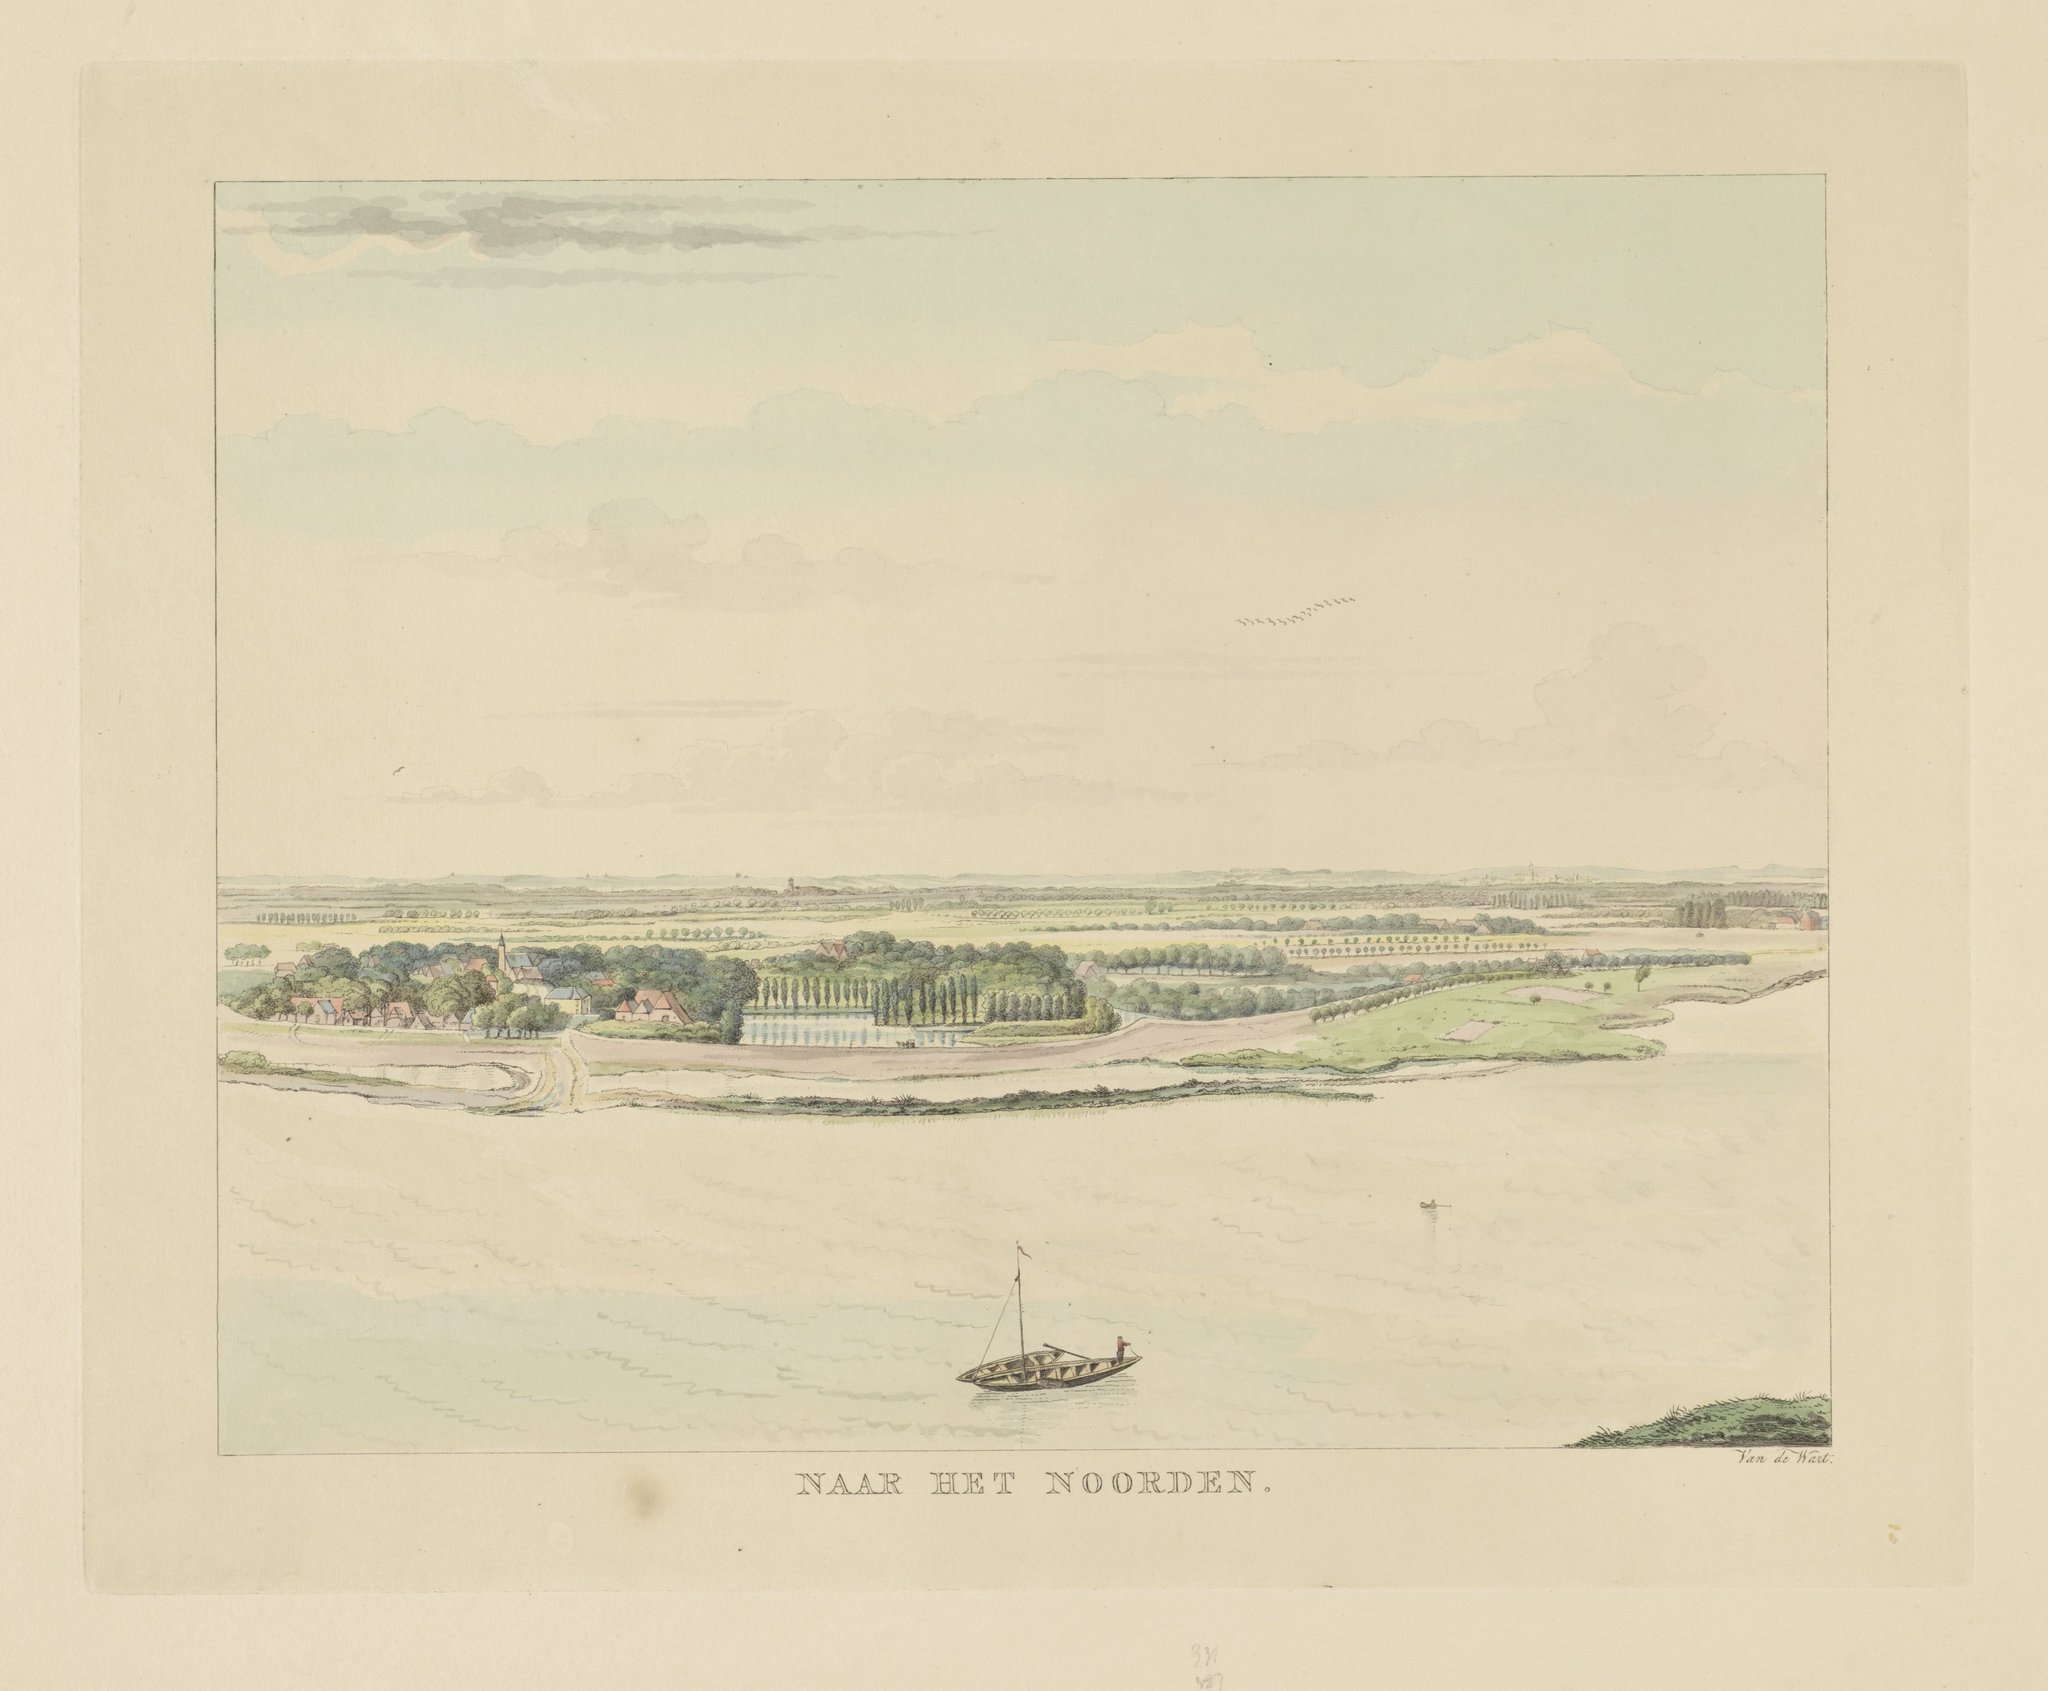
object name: watercolor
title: Gezicht op de Waal ten noorden van Nijmegen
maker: derk anthony van de wart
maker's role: draughtsman, painter, print maker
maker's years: 1767-1824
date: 1815-1824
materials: paper, watercolor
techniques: brush, etching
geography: nijmegen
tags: river, nijmegen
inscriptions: collector's mark: Lugt 2228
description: Vooraan stroomt de Waal. Op de rivier vaart een boot. Aan de overkant van de rivier ligt links Lent en rechts Huis Doornik. De prent is een onderdeel van een suite van negen prenten, inclusief de titelprent.